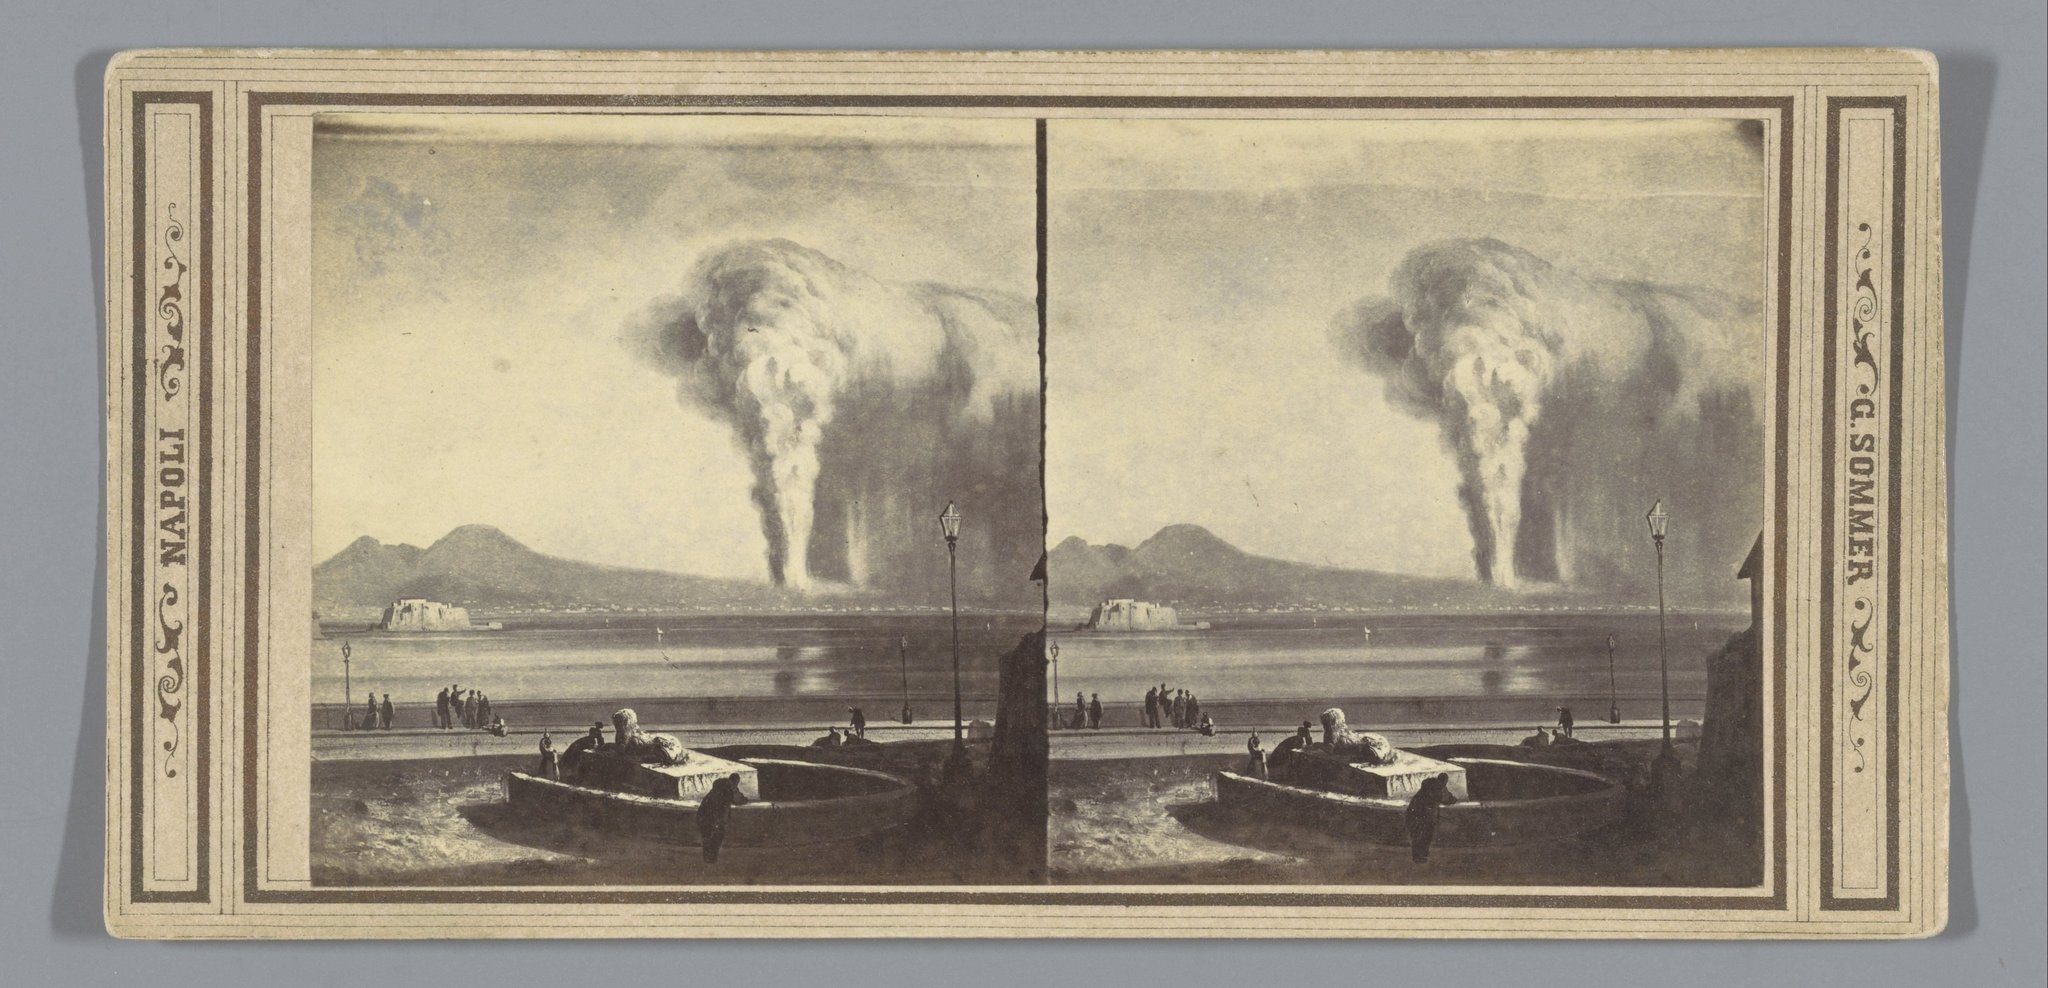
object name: stereograph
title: Napoli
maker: giorgio sommer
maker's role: fotograaf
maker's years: 1834-1914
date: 1860-1880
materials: cardboard, photographic support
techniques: albumen print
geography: naples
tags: eruption (of volcano), mount vesuvius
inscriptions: inscription: ‘Eruzione del 8 Xbre 1861’, number: ‘K 8.’